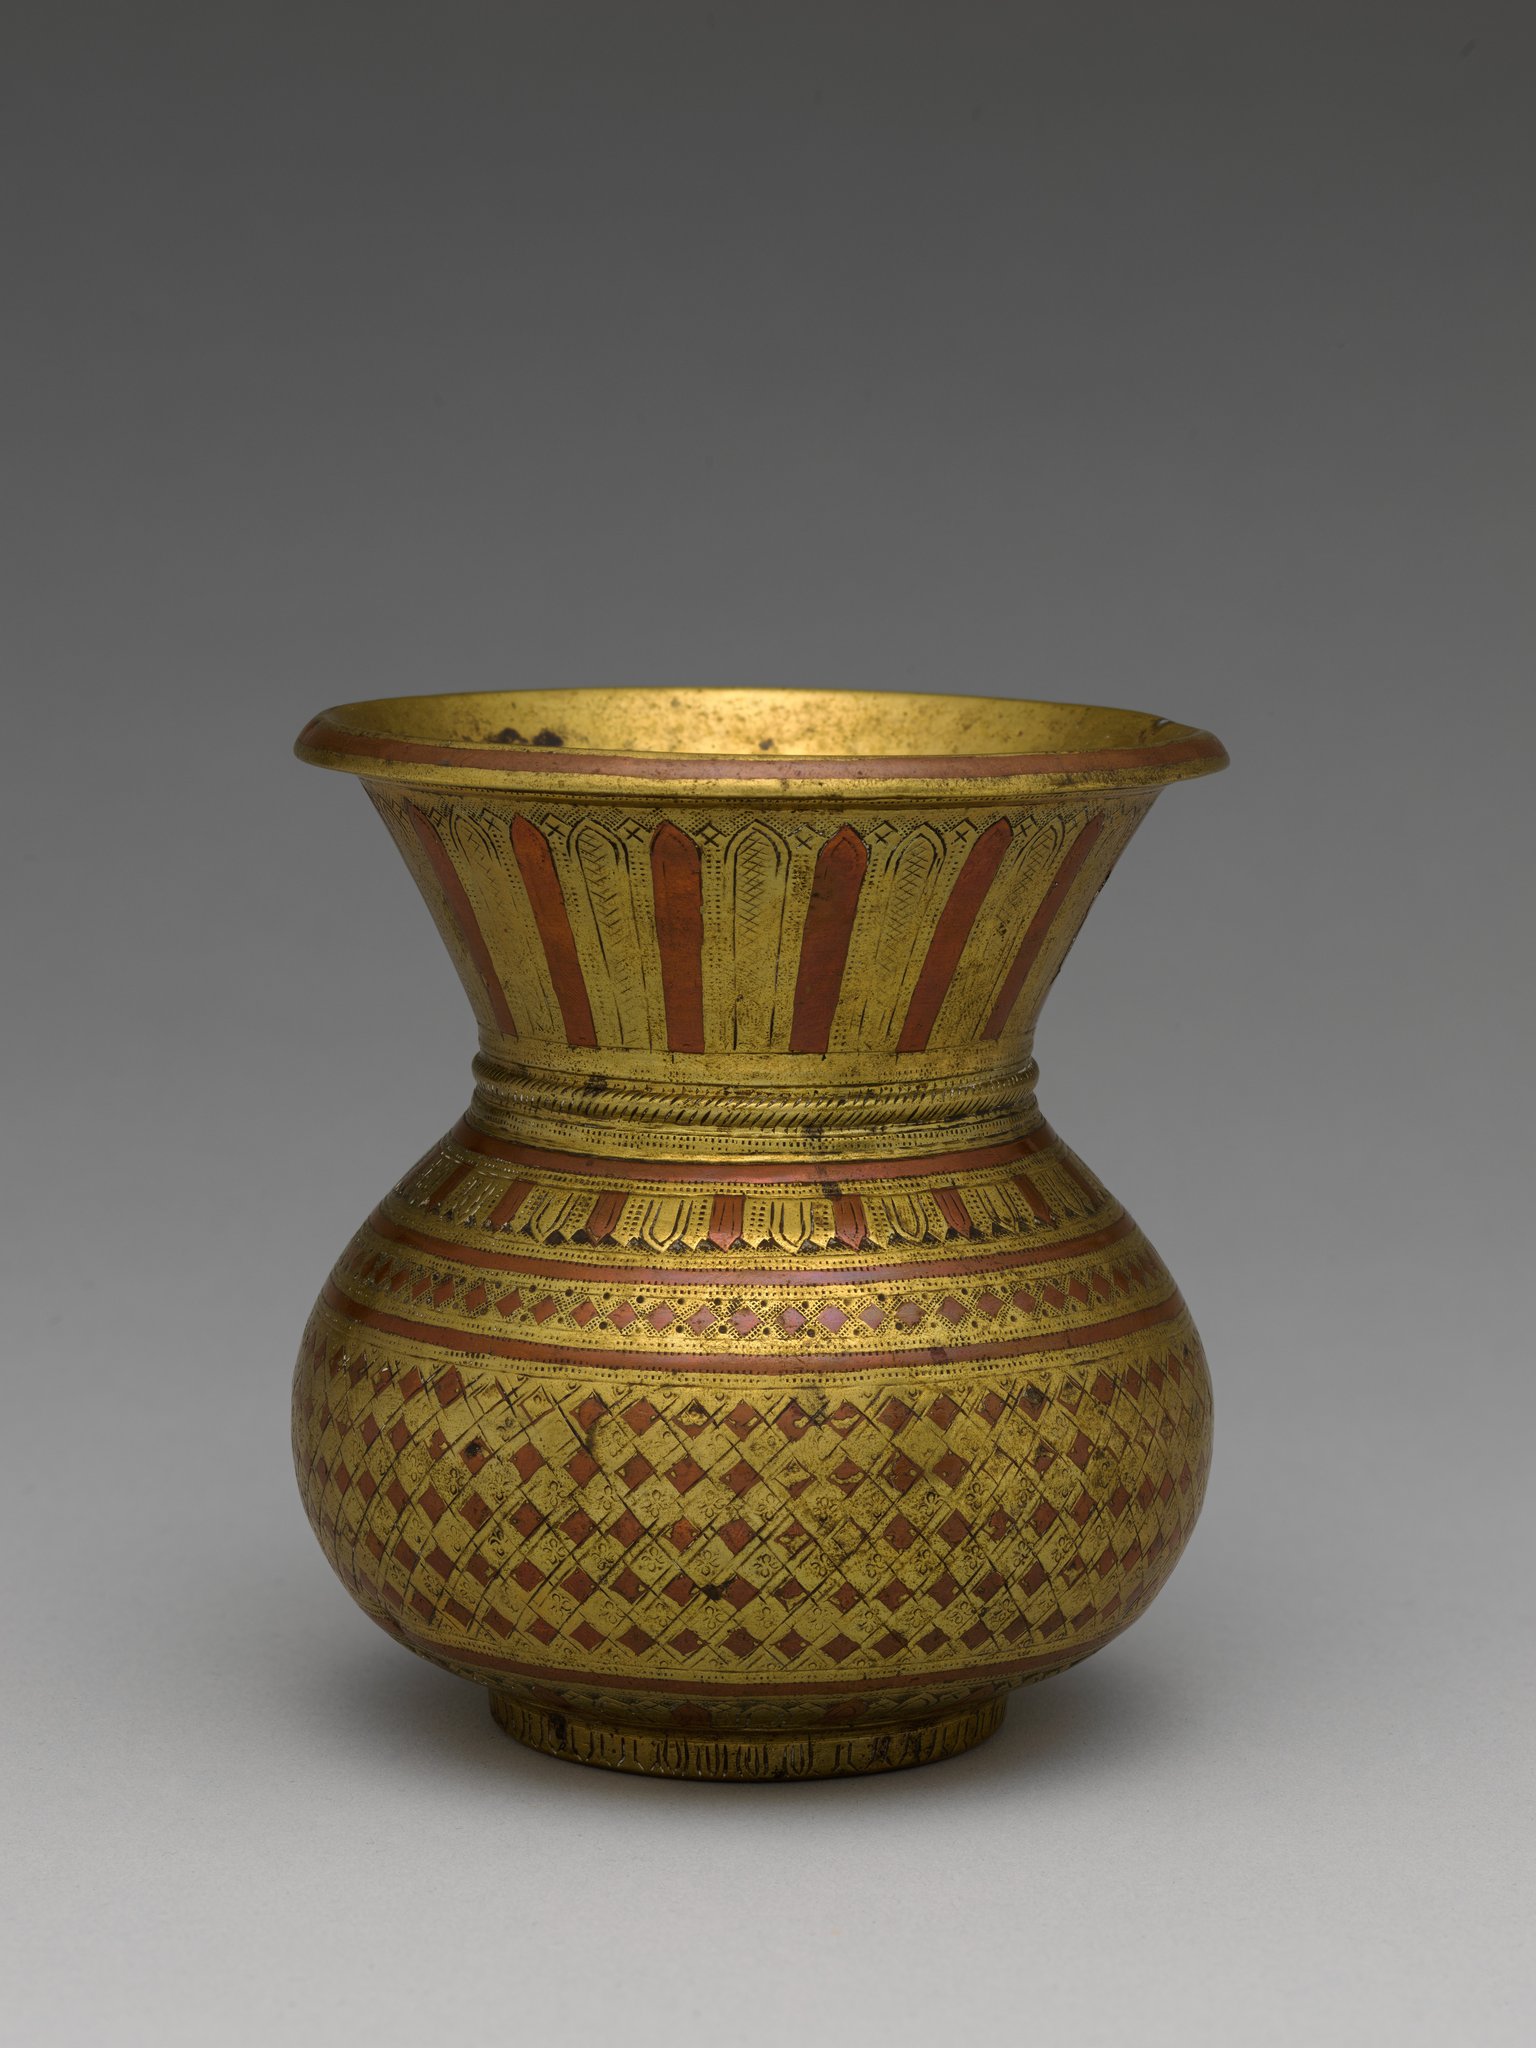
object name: water container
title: Water Container (Ganga-Jumna Lota)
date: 1801-1900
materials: brass, copper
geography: india